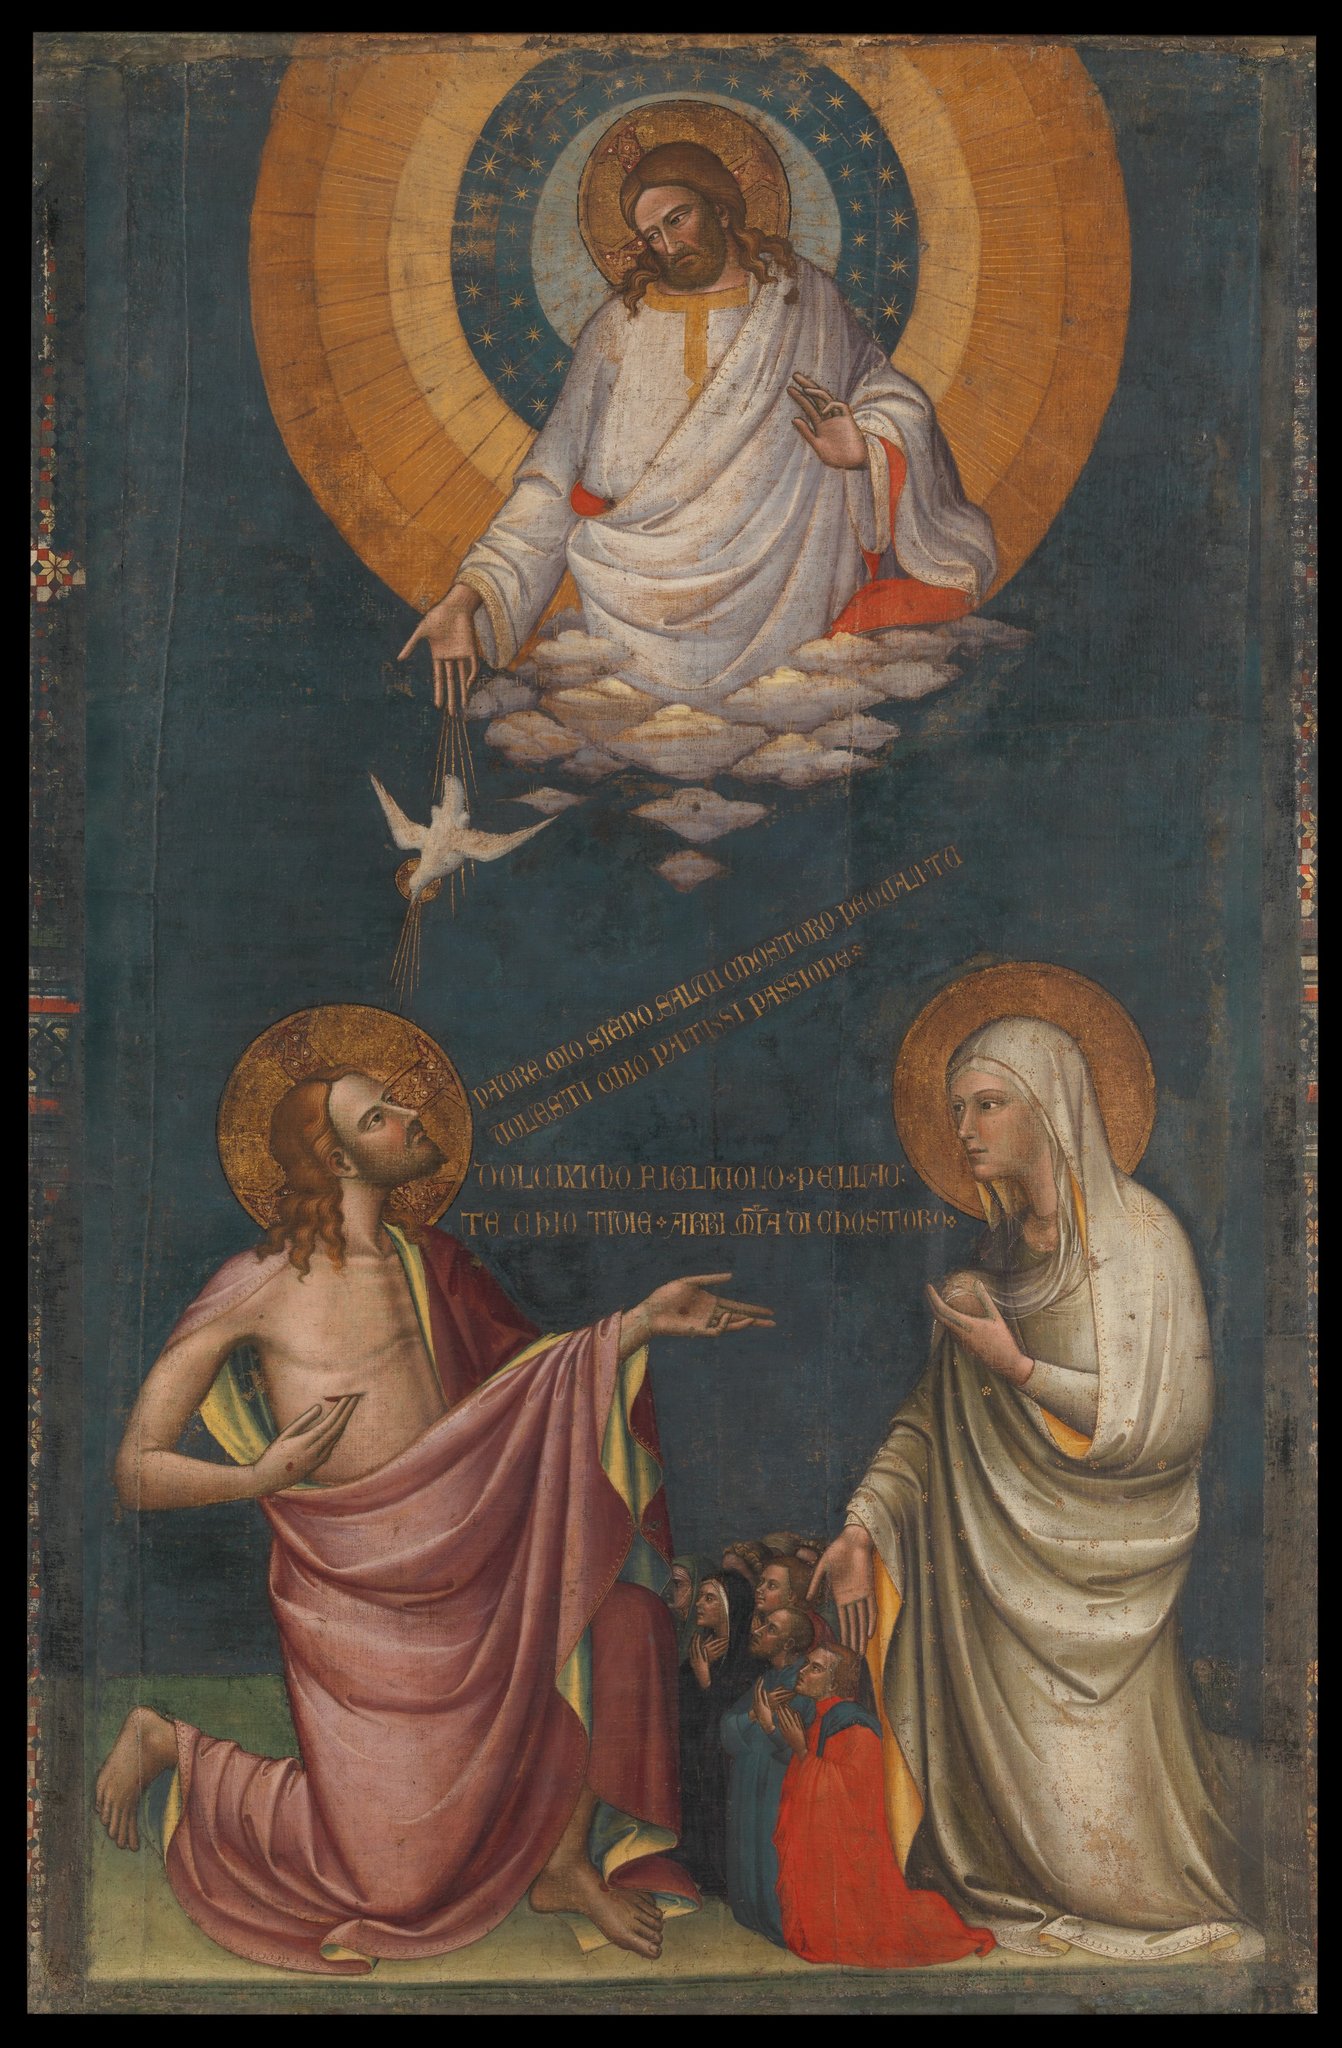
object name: painting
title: The Intercession of Christ and the Virgin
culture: italian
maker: lorenzo monaco (piero di giovanni)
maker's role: artist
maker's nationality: italian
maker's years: 1370-1425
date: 1402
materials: canvas, paint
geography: italy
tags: doves,christ,virgin mary,god the father